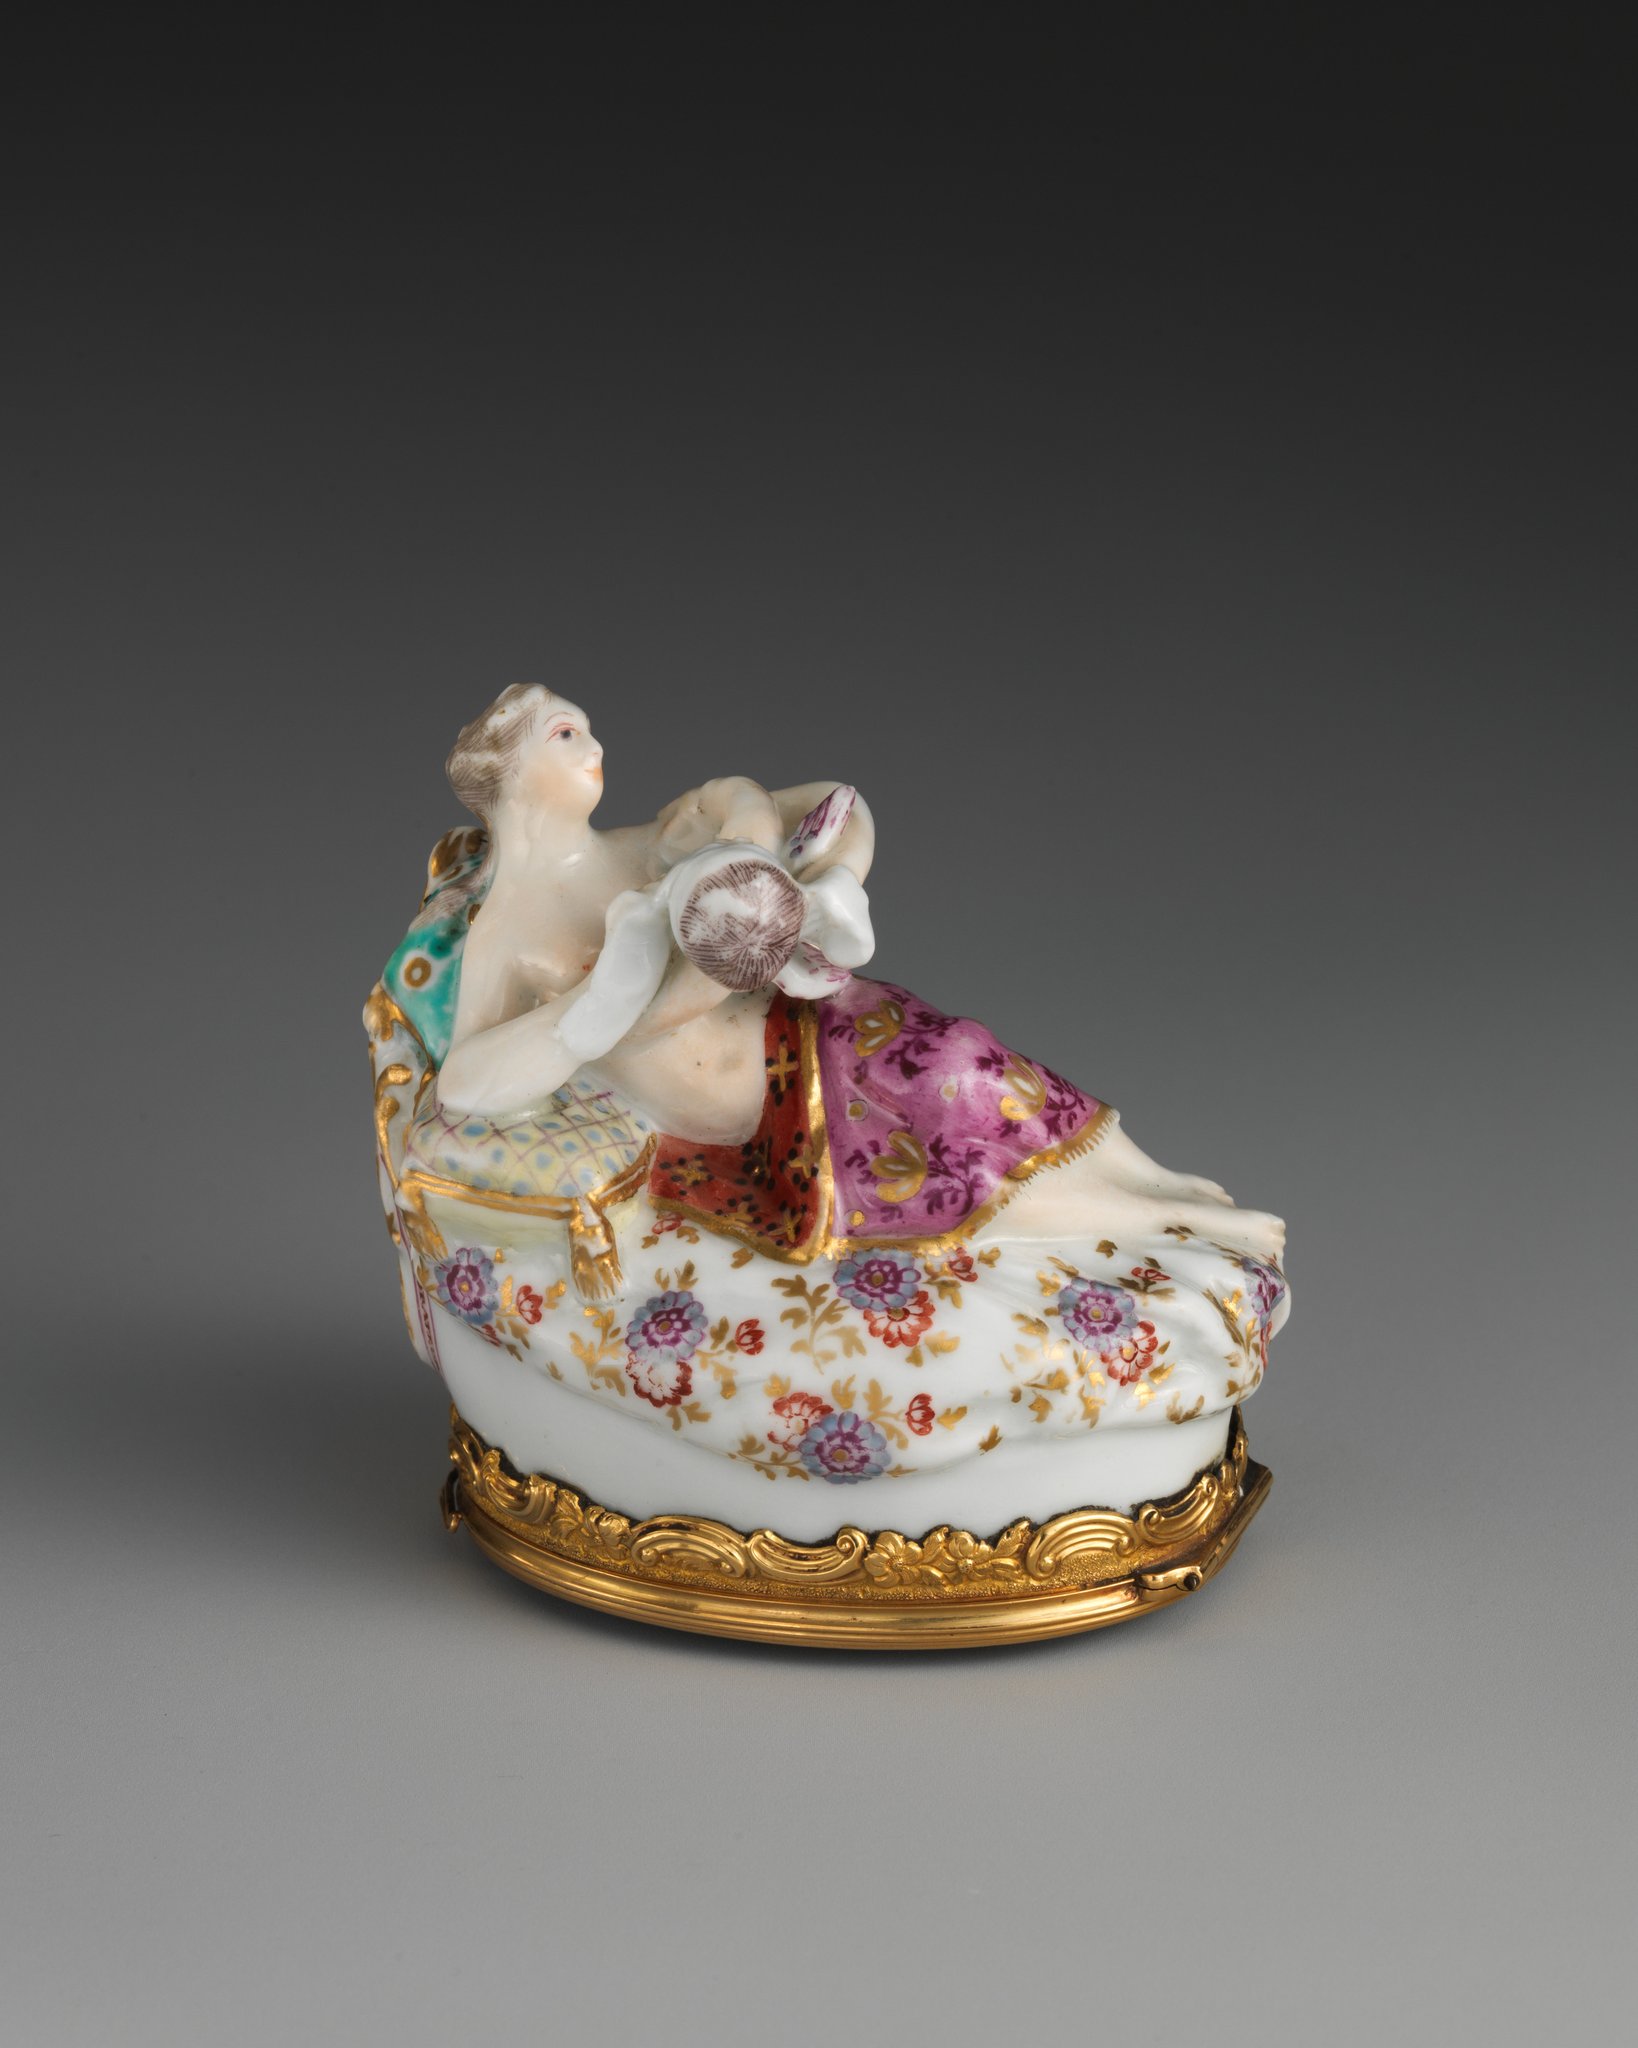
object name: toy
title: Venus and Cupid in a group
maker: chelsea porcelain manufactory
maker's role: factory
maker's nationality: british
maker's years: 1744-1784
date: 1755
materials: soft paste porcelain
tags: cupid,venus,flowers